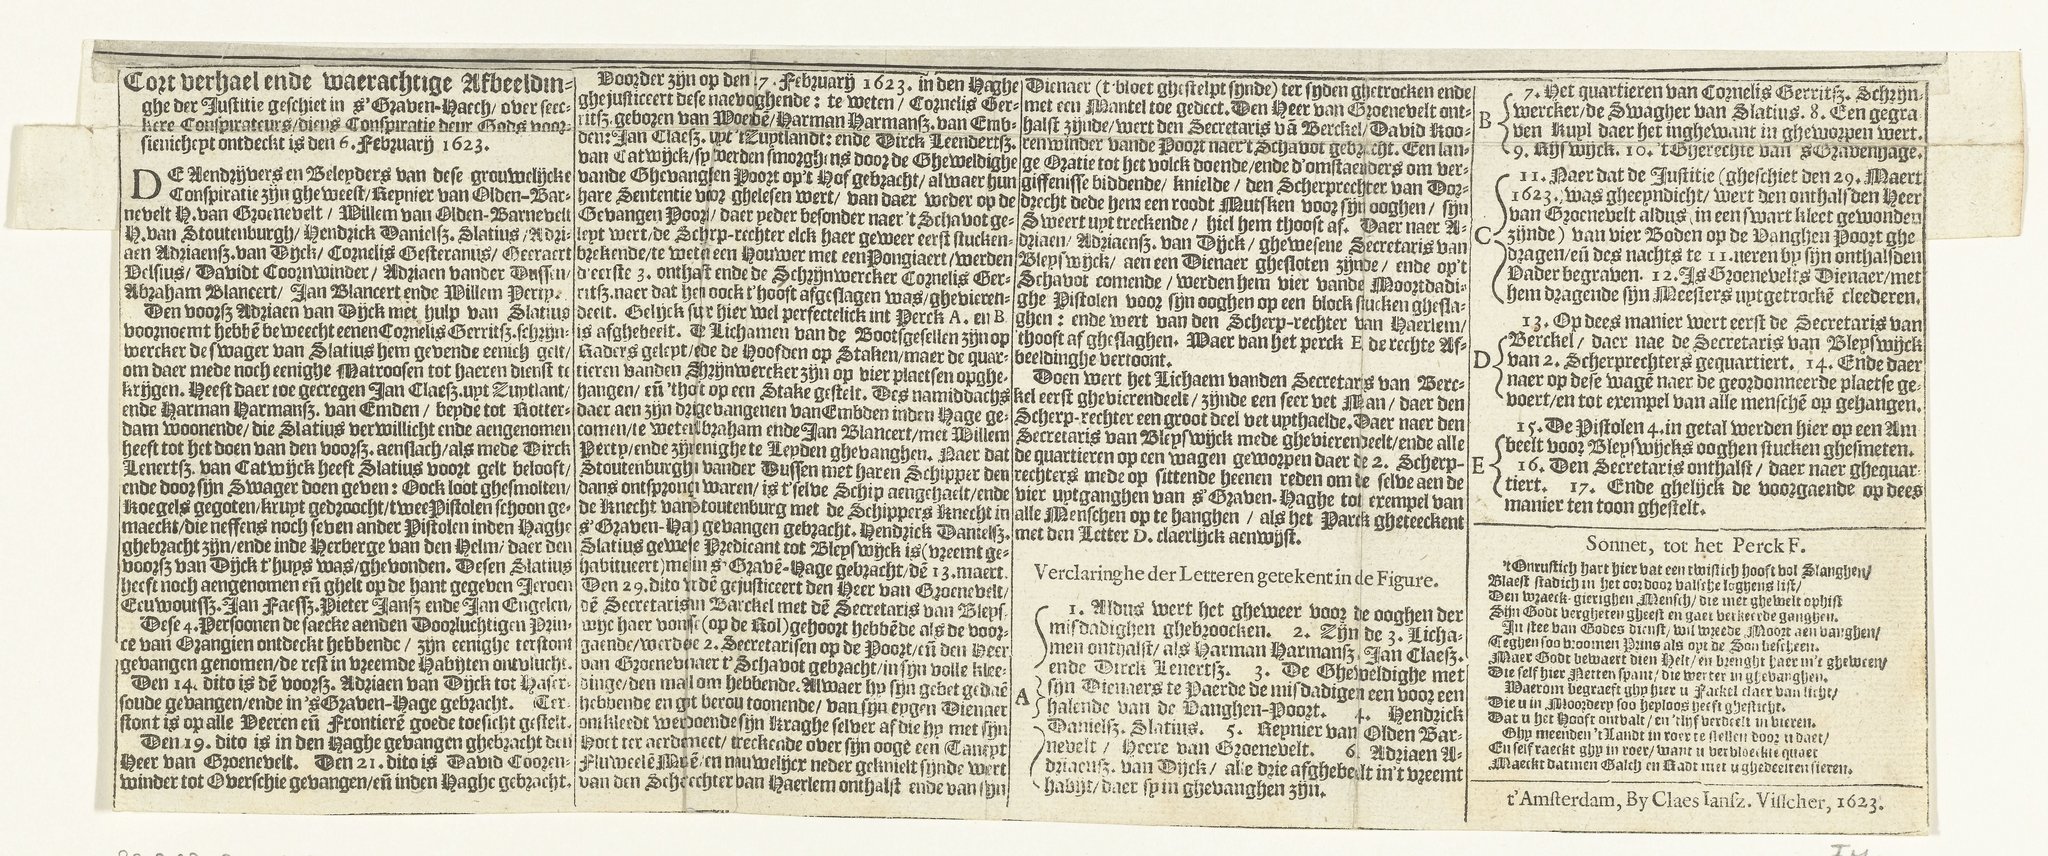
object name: print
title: Tekstblad bij de prent van de executie van Reinier van Oldenbarnevelt, David Coorenwinder en Adriaan van Dijk, 1623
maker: claes jansz. visscher (ii)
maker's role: draughtsman, print maker, publisher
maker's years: 1586-1652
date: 1623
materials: paper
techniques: letterpress printing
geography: amsterdam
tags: maurice (prince of orange), (revolutionary) plot, conspiracy, on the scaffold or place of execution, mutilation of the corpse, violent death by beheading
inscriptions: date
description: Tekstblad bij de prent van de executies van Reinier van Oldenbarnevelt, David Coorenwinder en Adriaan van Dijk, 29 maart 1623, op het schavot op het Groene Zoodje te Den Haag.